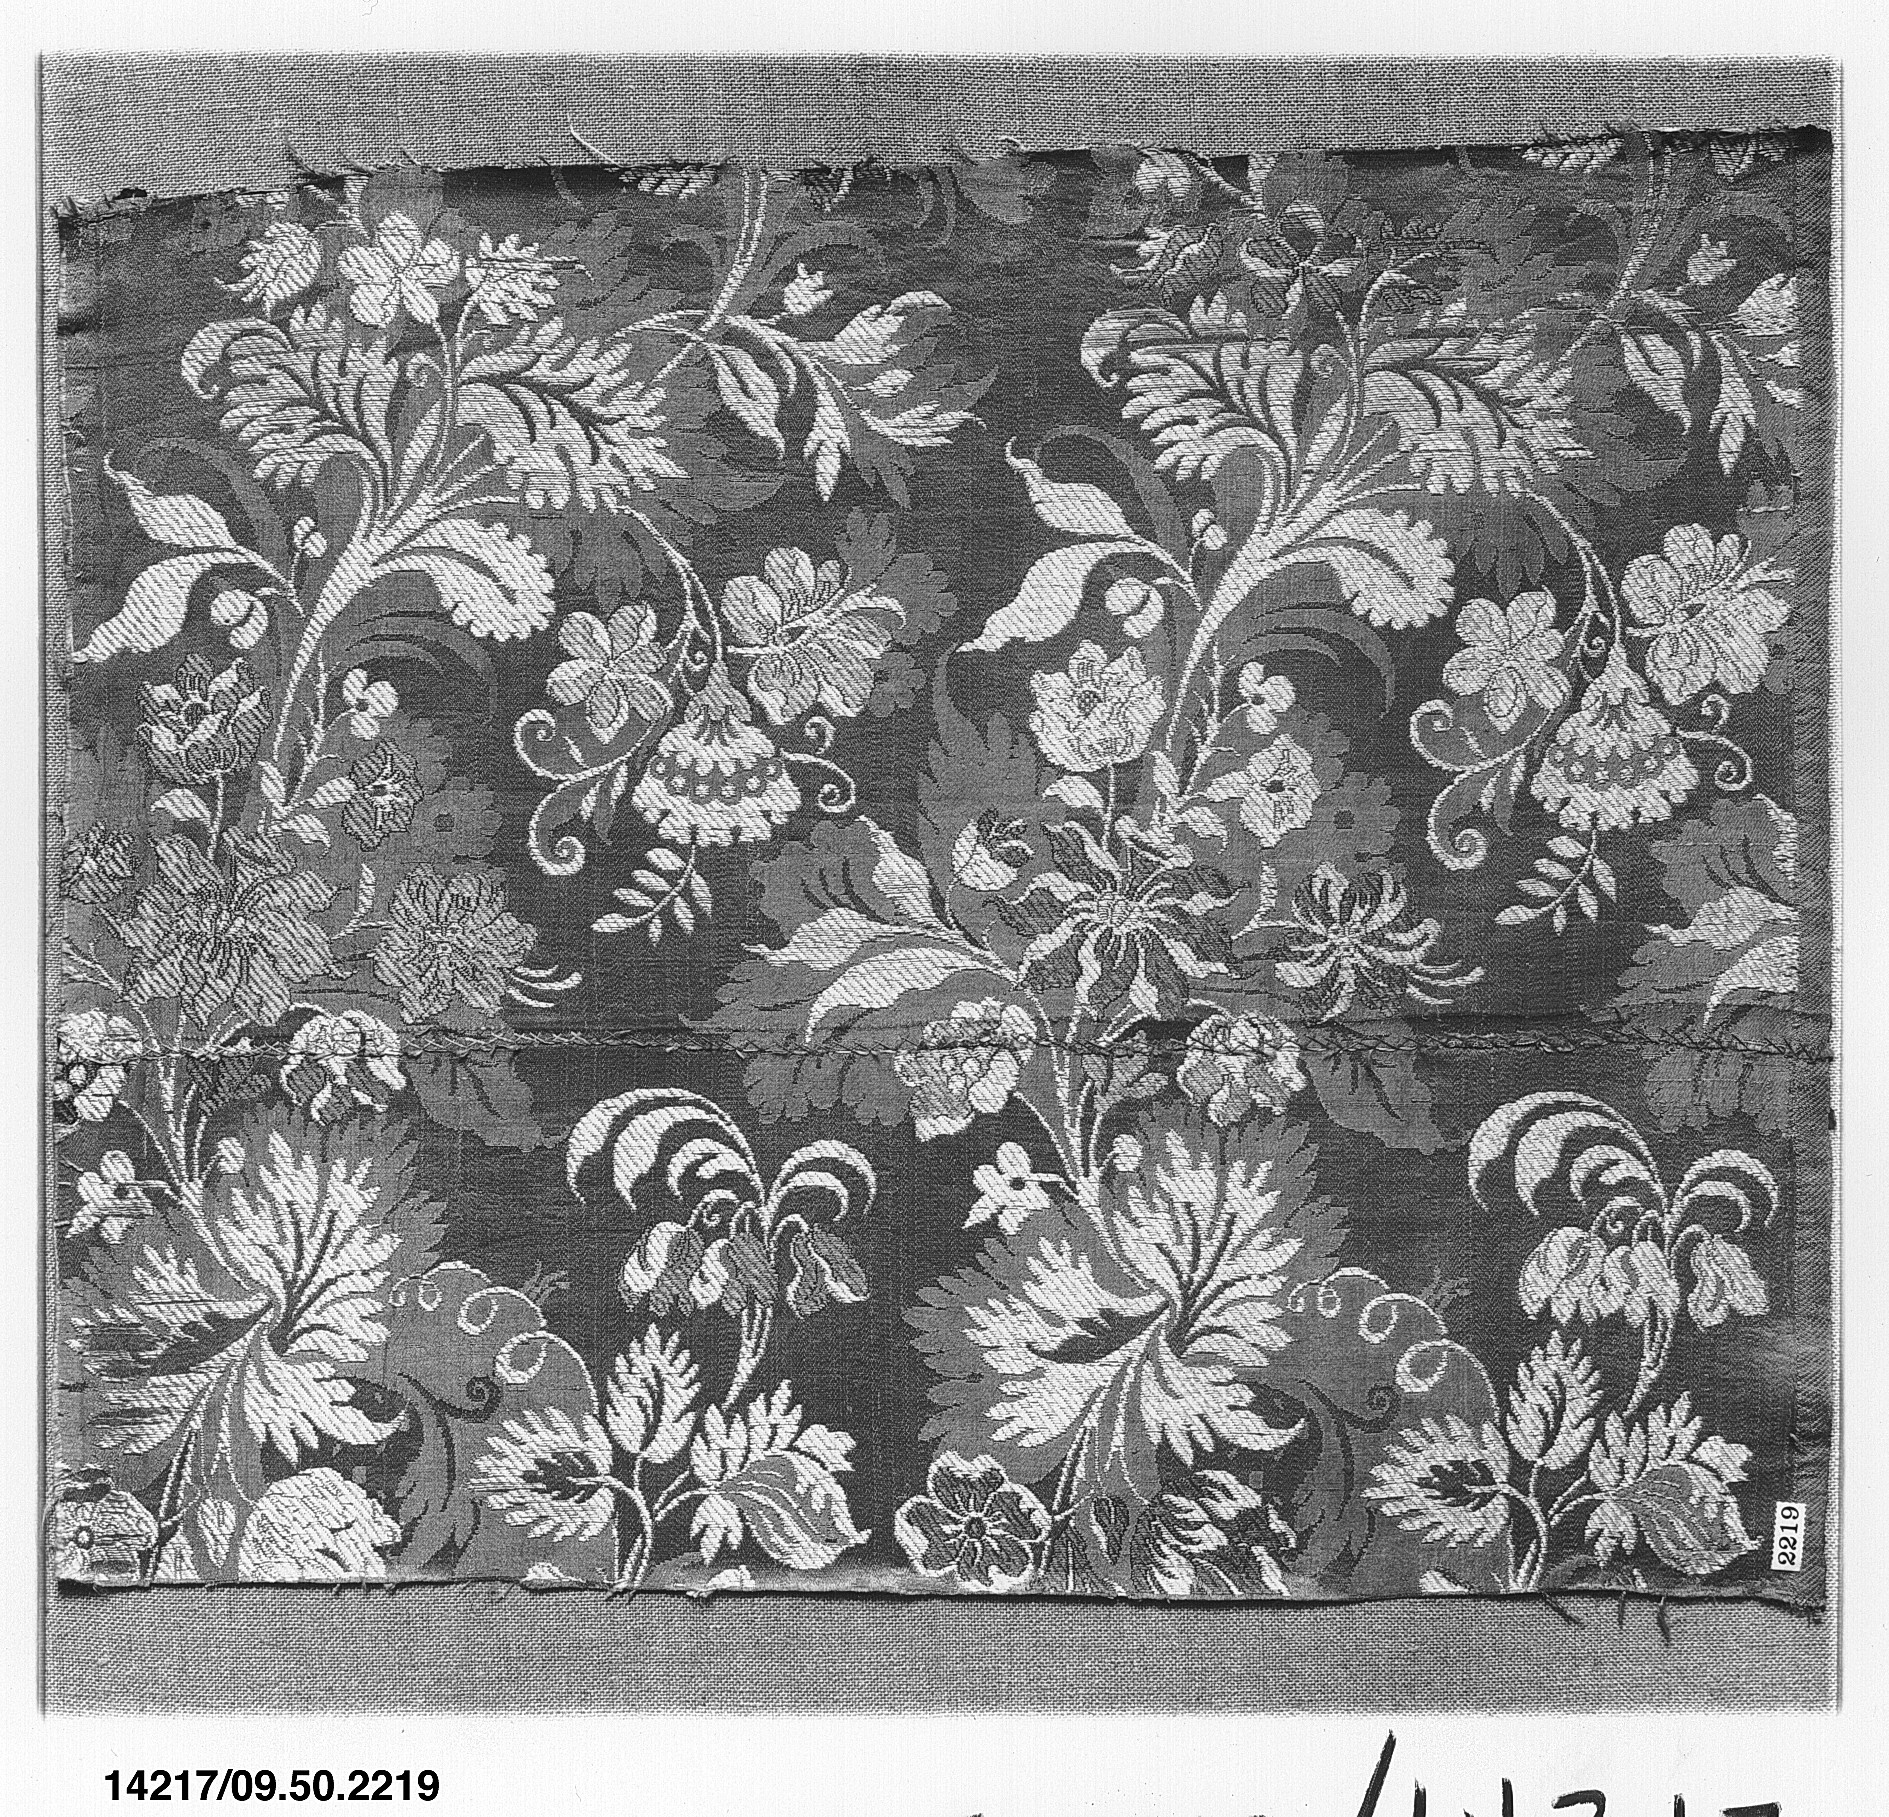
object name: piece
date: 1734-1766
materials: silk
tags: flowers,leaves